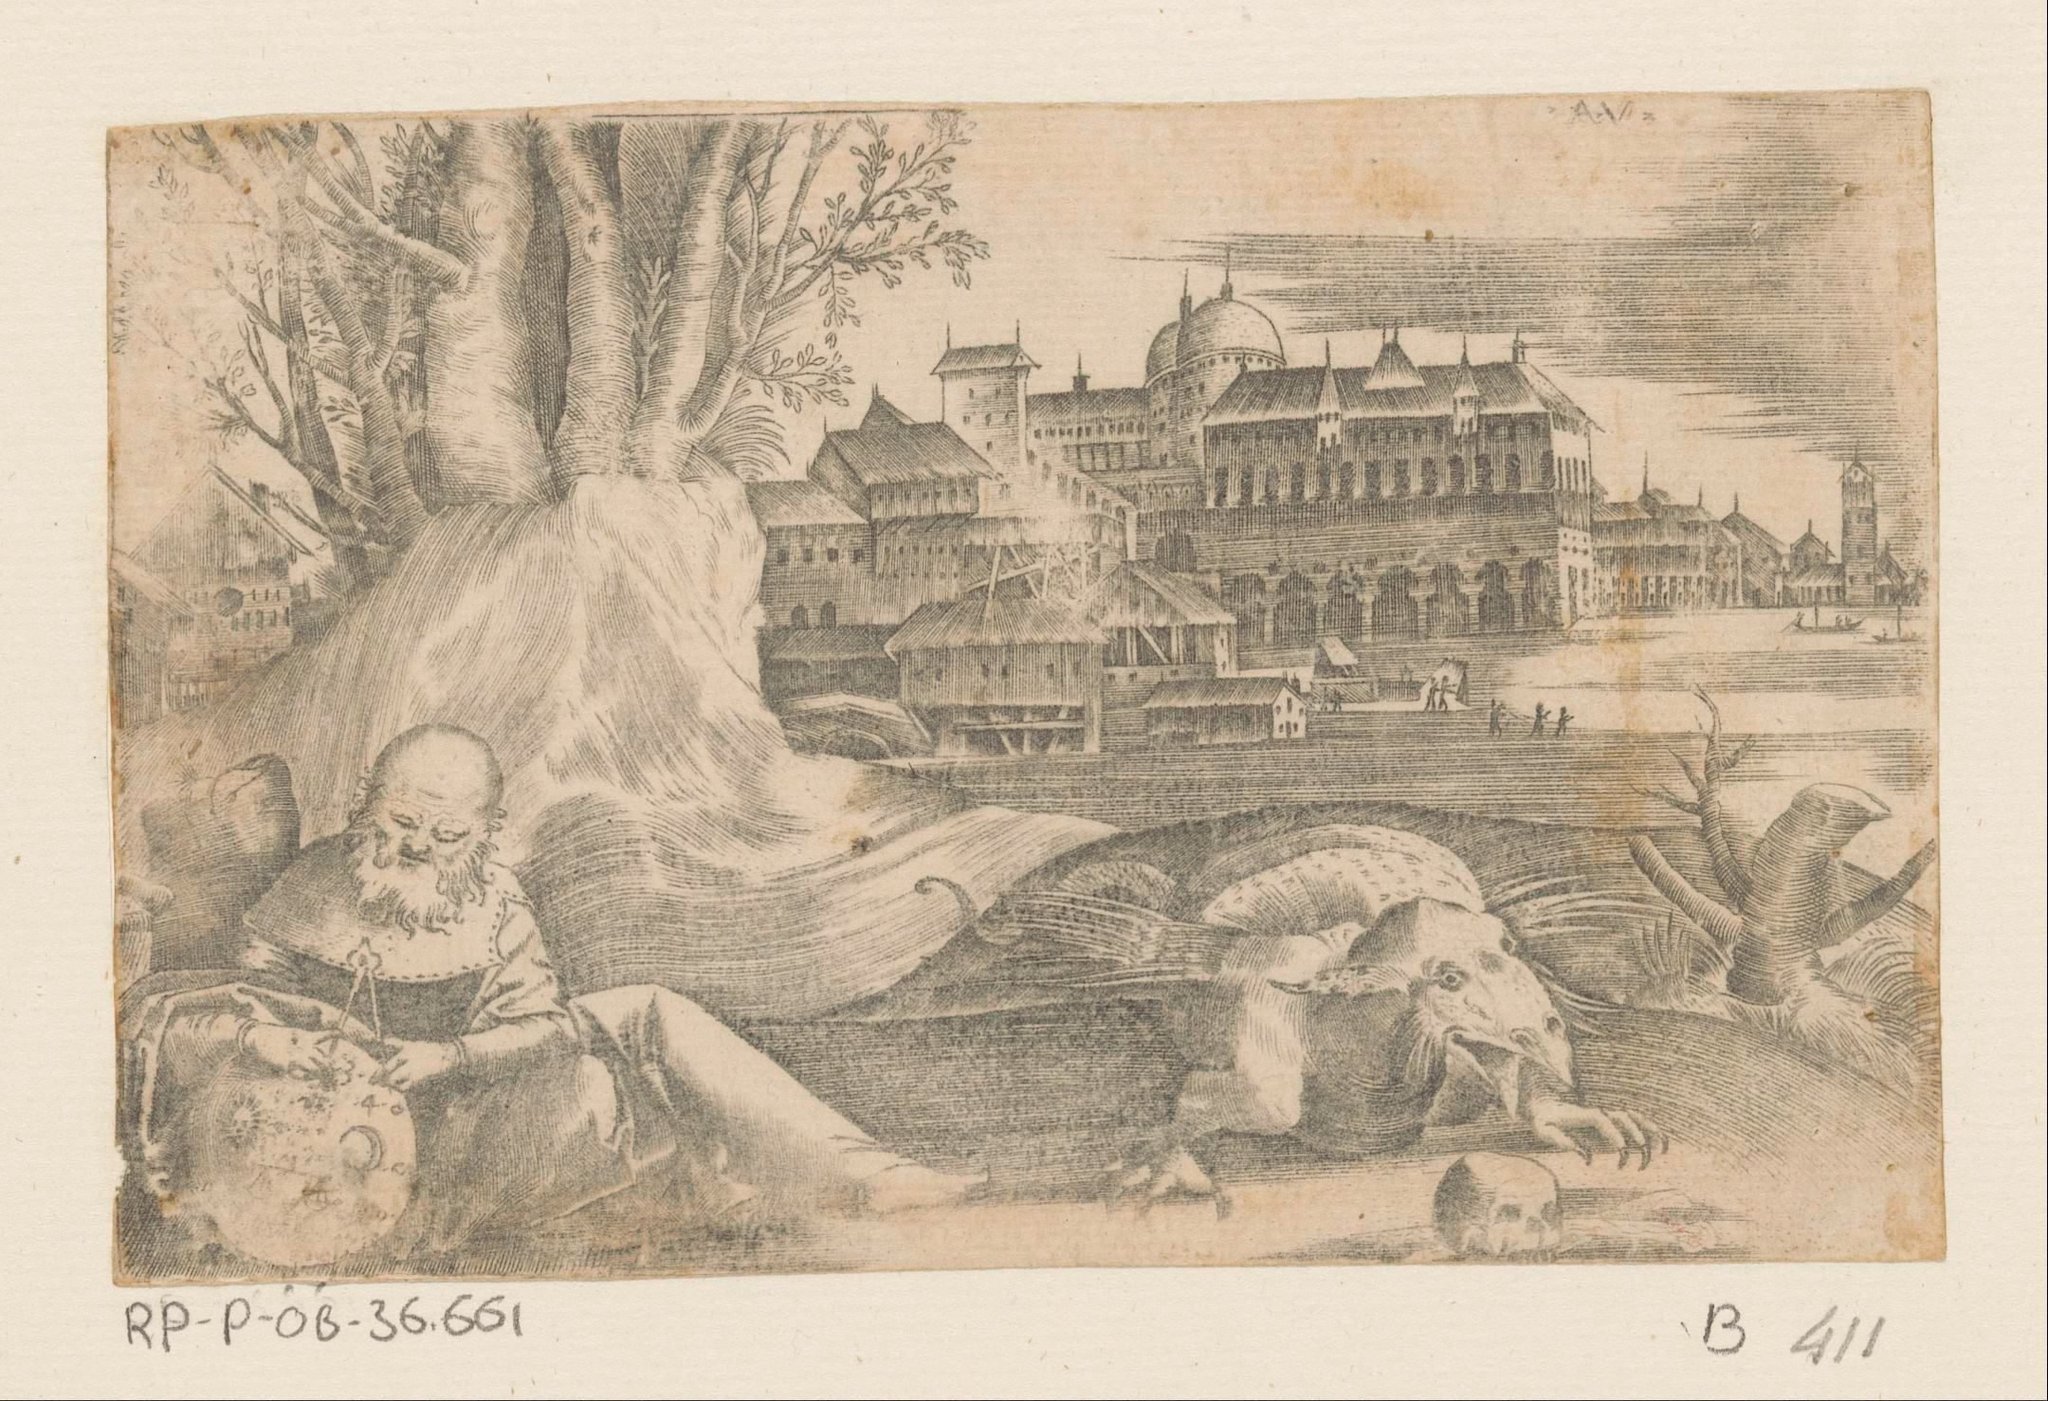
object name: print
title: Astroloog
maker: agostino veneziano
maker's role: draughtsman, painter, print maker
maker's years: 1490-1536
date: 1514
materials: paper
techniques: engraving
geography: italy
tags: (human) skull, astrologer at work, mis-shapen animals; monsters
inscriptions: collector's mark: Lugt 12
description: Kopie naar een prent van Giulio Campagnola. De originele prent door Campagnola bevat het jaartal 1509 onderaan de wereldbol. Er bestaat echter discussie over de interpretatie van deze cijfers als zijnde de datering van de prent. Vanwege de kwaliteit van de afdruk is onduidelijk of deze prent door Agostino Veneziano wel of niet onderaan de wereldbol gedateerd is. Een exemplaar van deze prent in het British Museum te Londen is op die plaats gedateerd 1514.